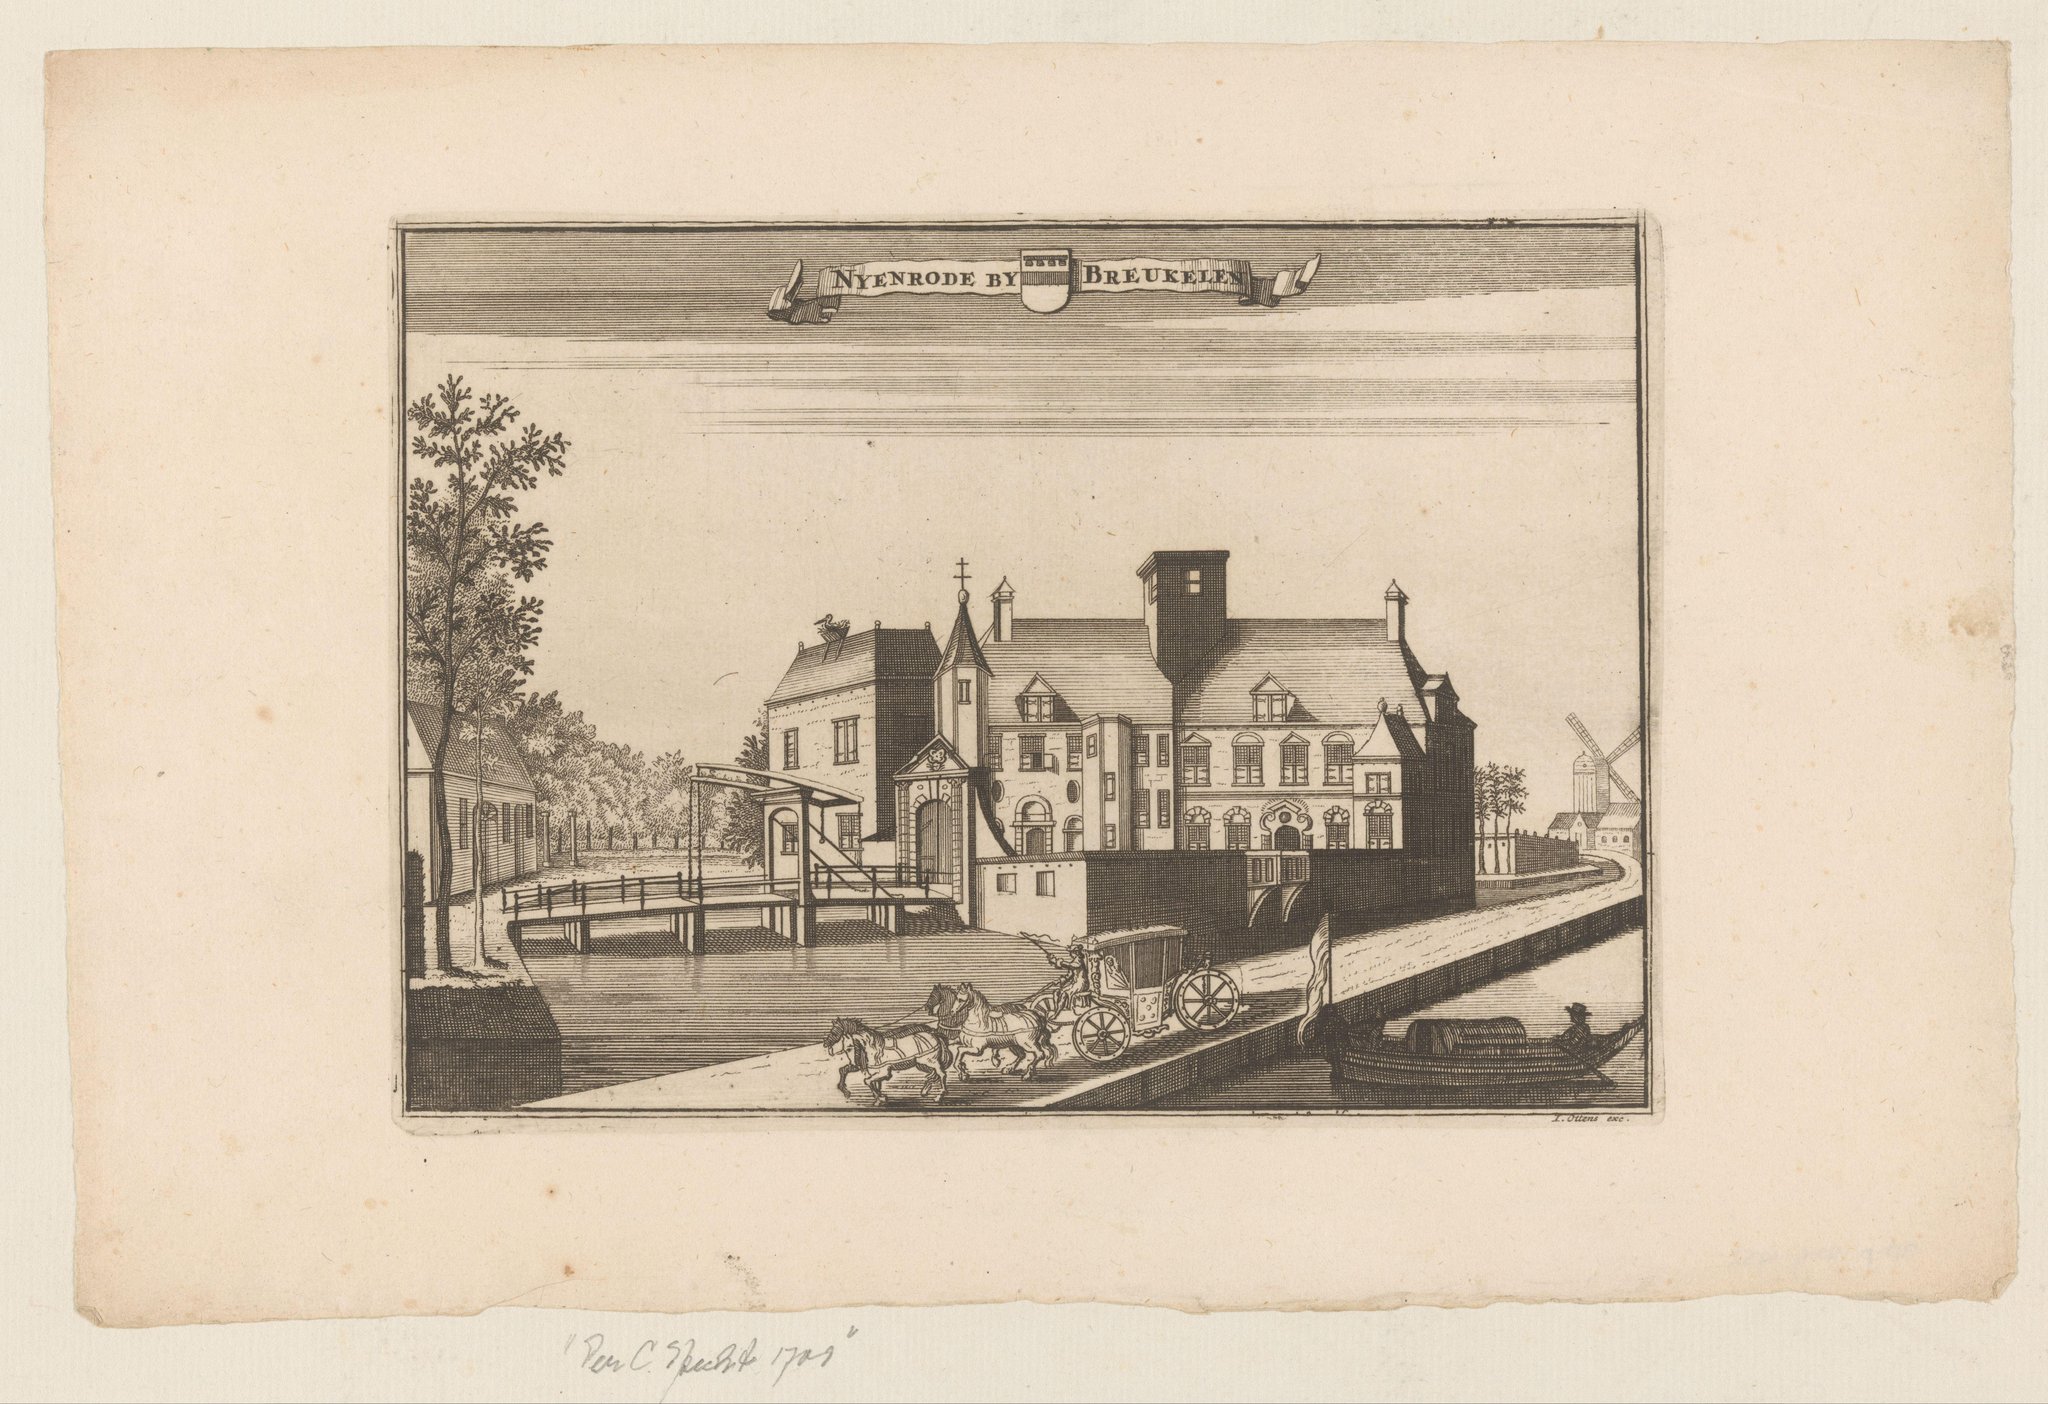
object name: print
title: Nyenrode by Breukelen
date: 1710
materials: paper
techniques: engraving, etching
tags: castle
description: Prent uit: De Ridder-matige Huysen en Gesichten in de Provincie van Utrecht. Amsterdam: Joachim Ottens, [ca. 1710].